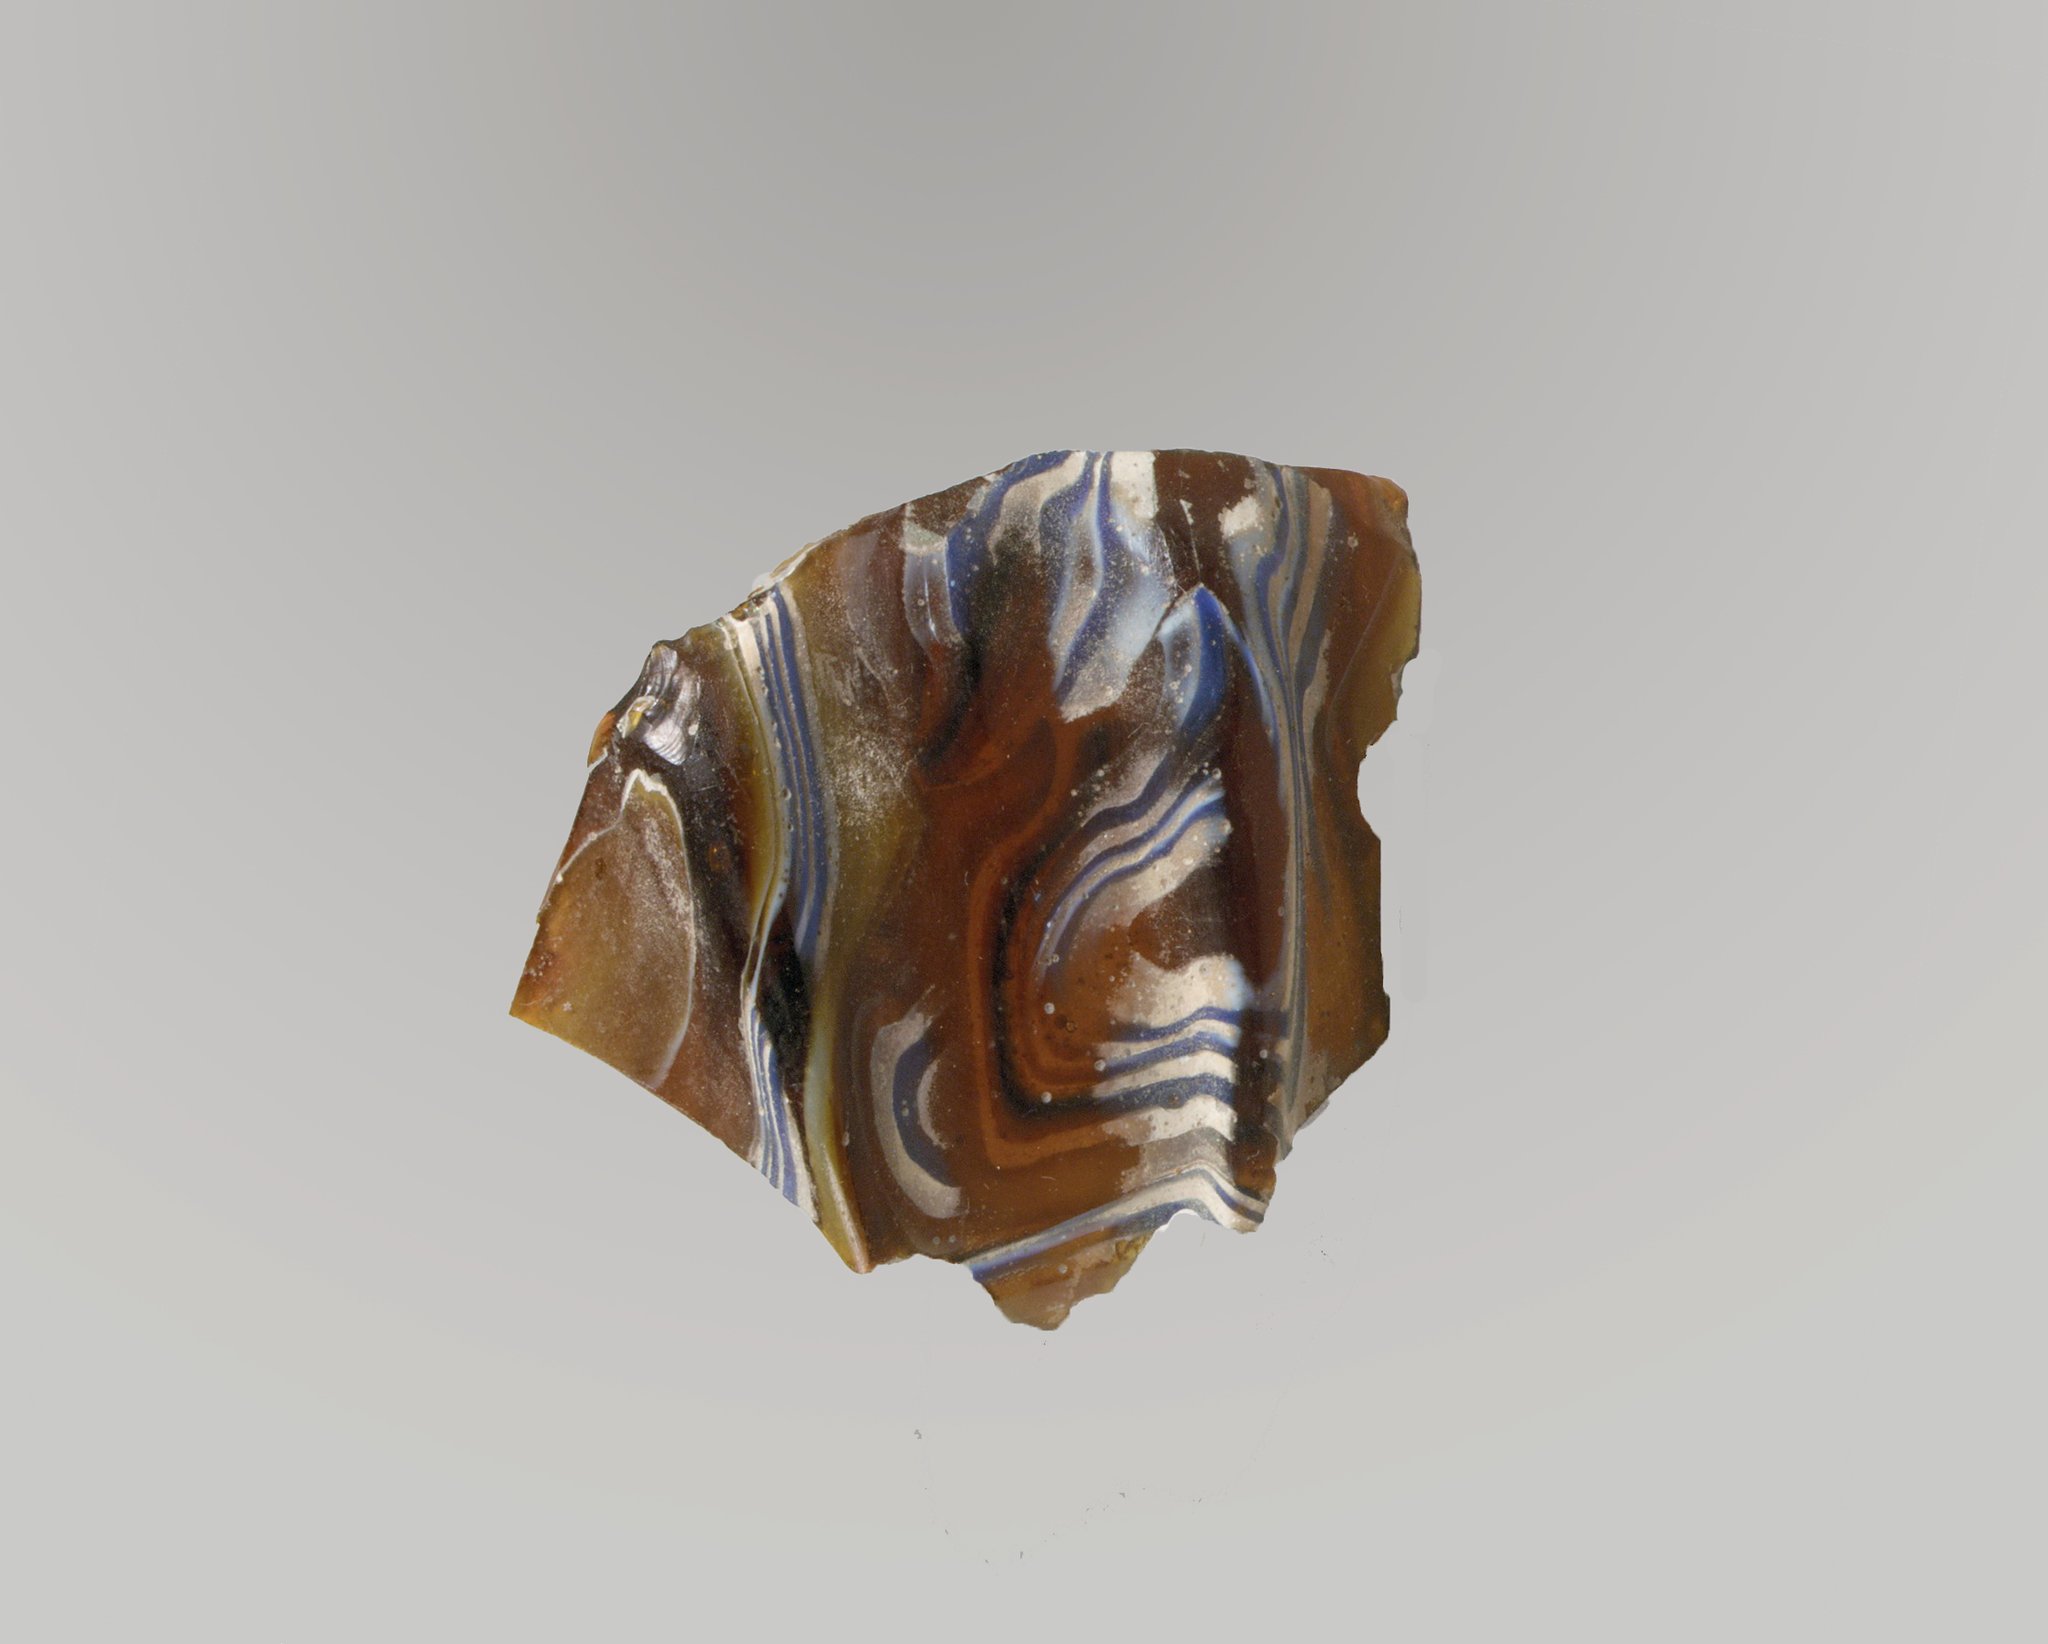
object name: fragment, mosaic bowl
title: Glass mosaic ribbed bowl fragment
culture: roman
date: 34 BCE-33 CE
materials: glass